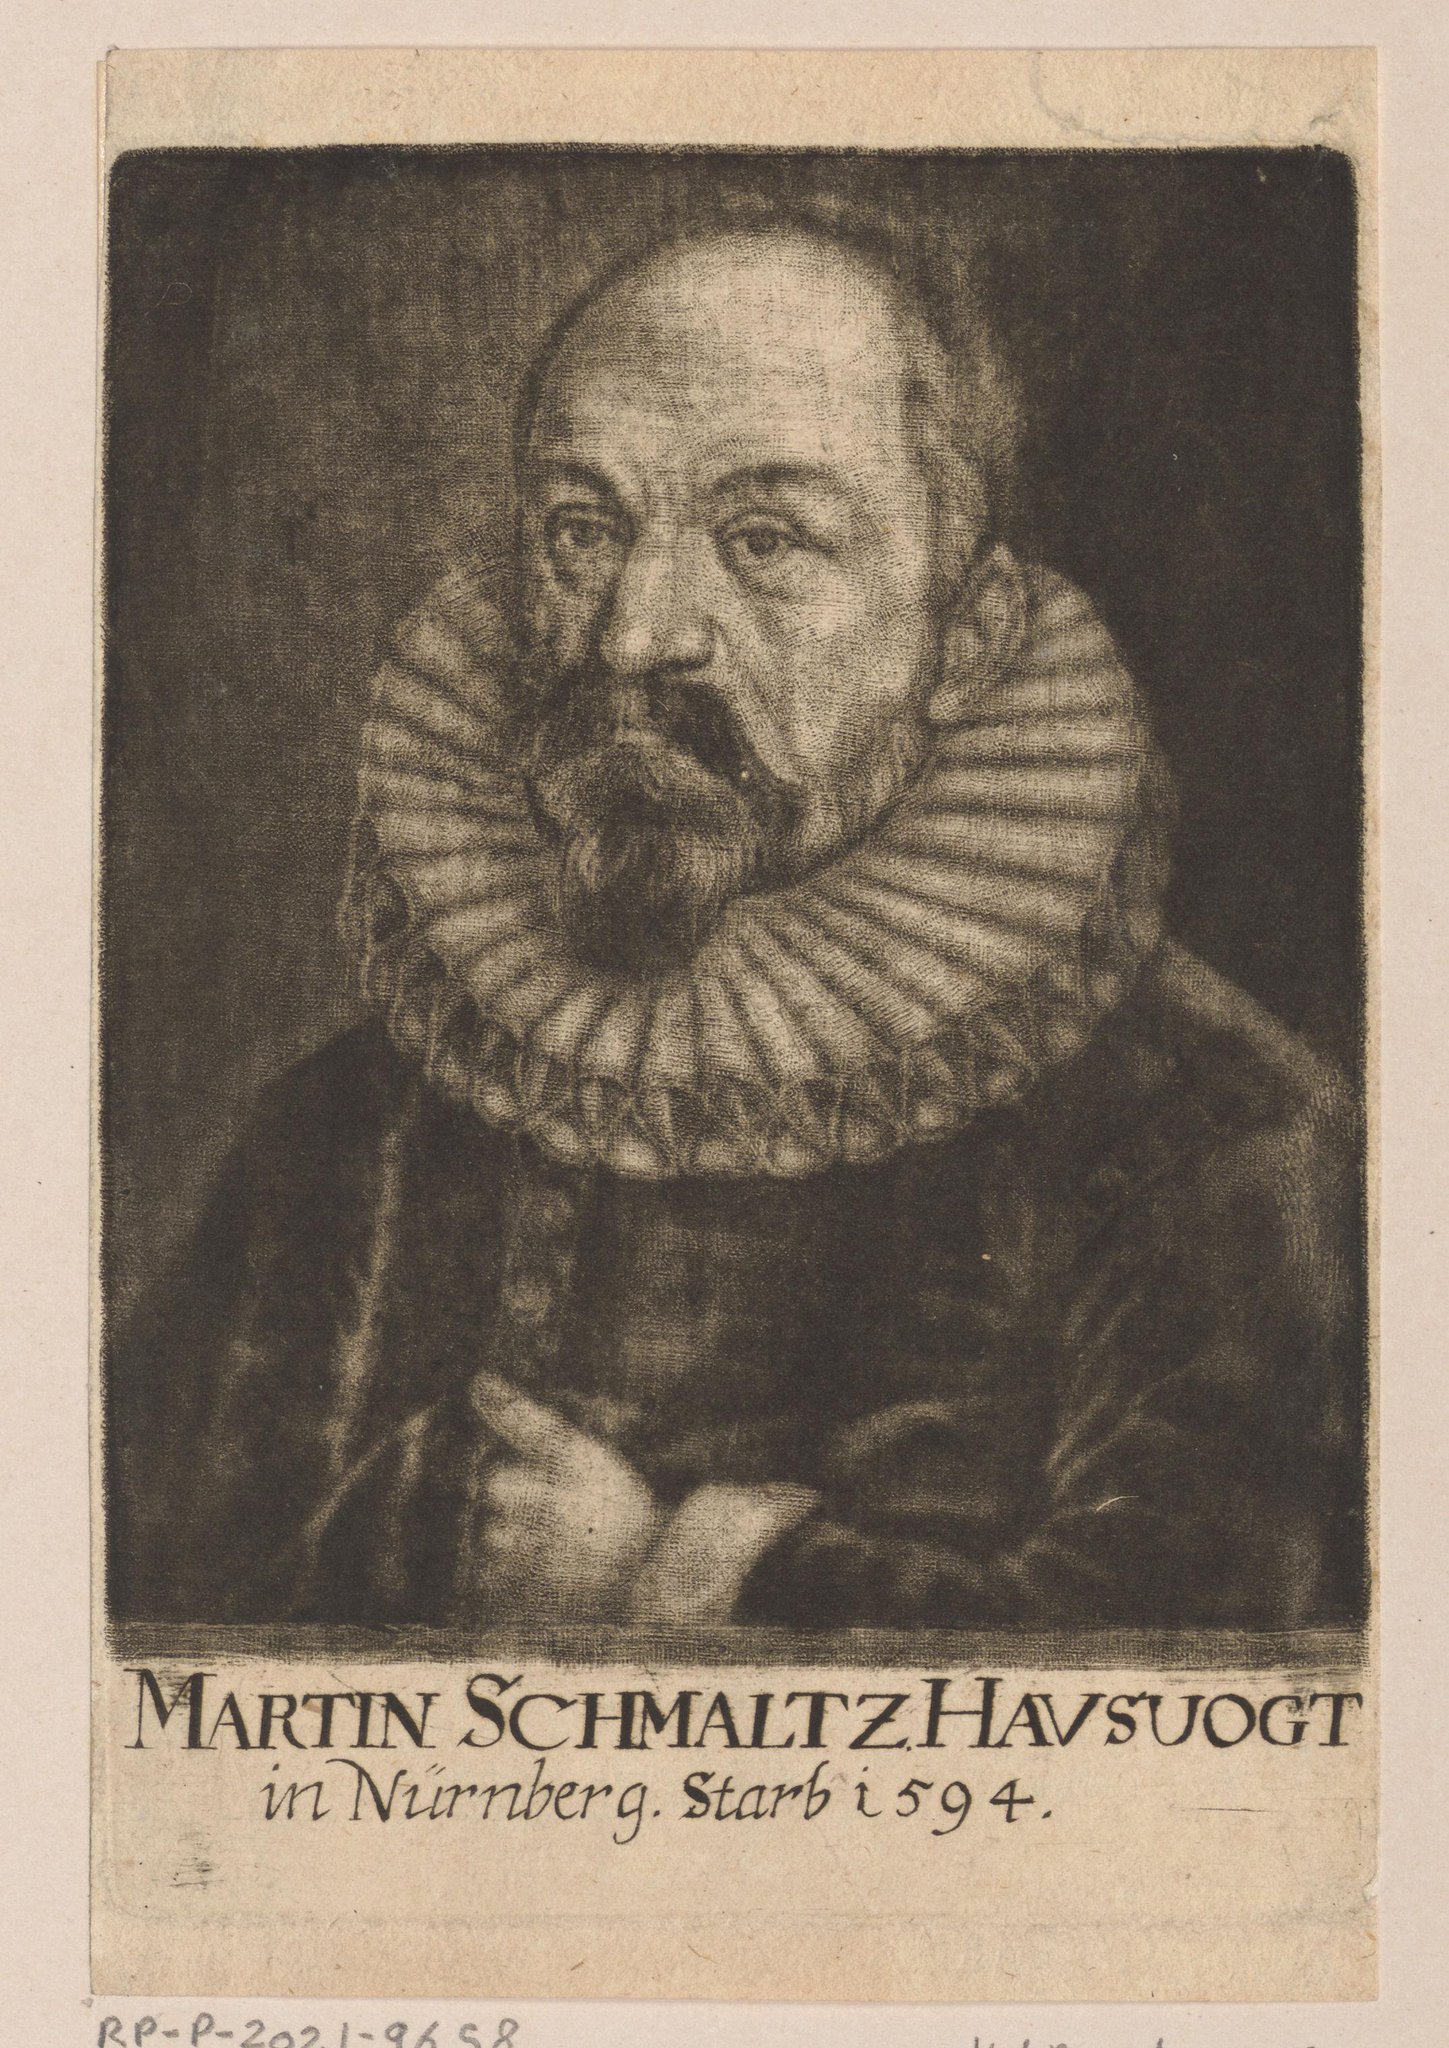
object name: print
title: Portret van Martin Schmaltz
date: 1656-1722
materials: paper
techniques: engraving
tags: adult man, historical persons